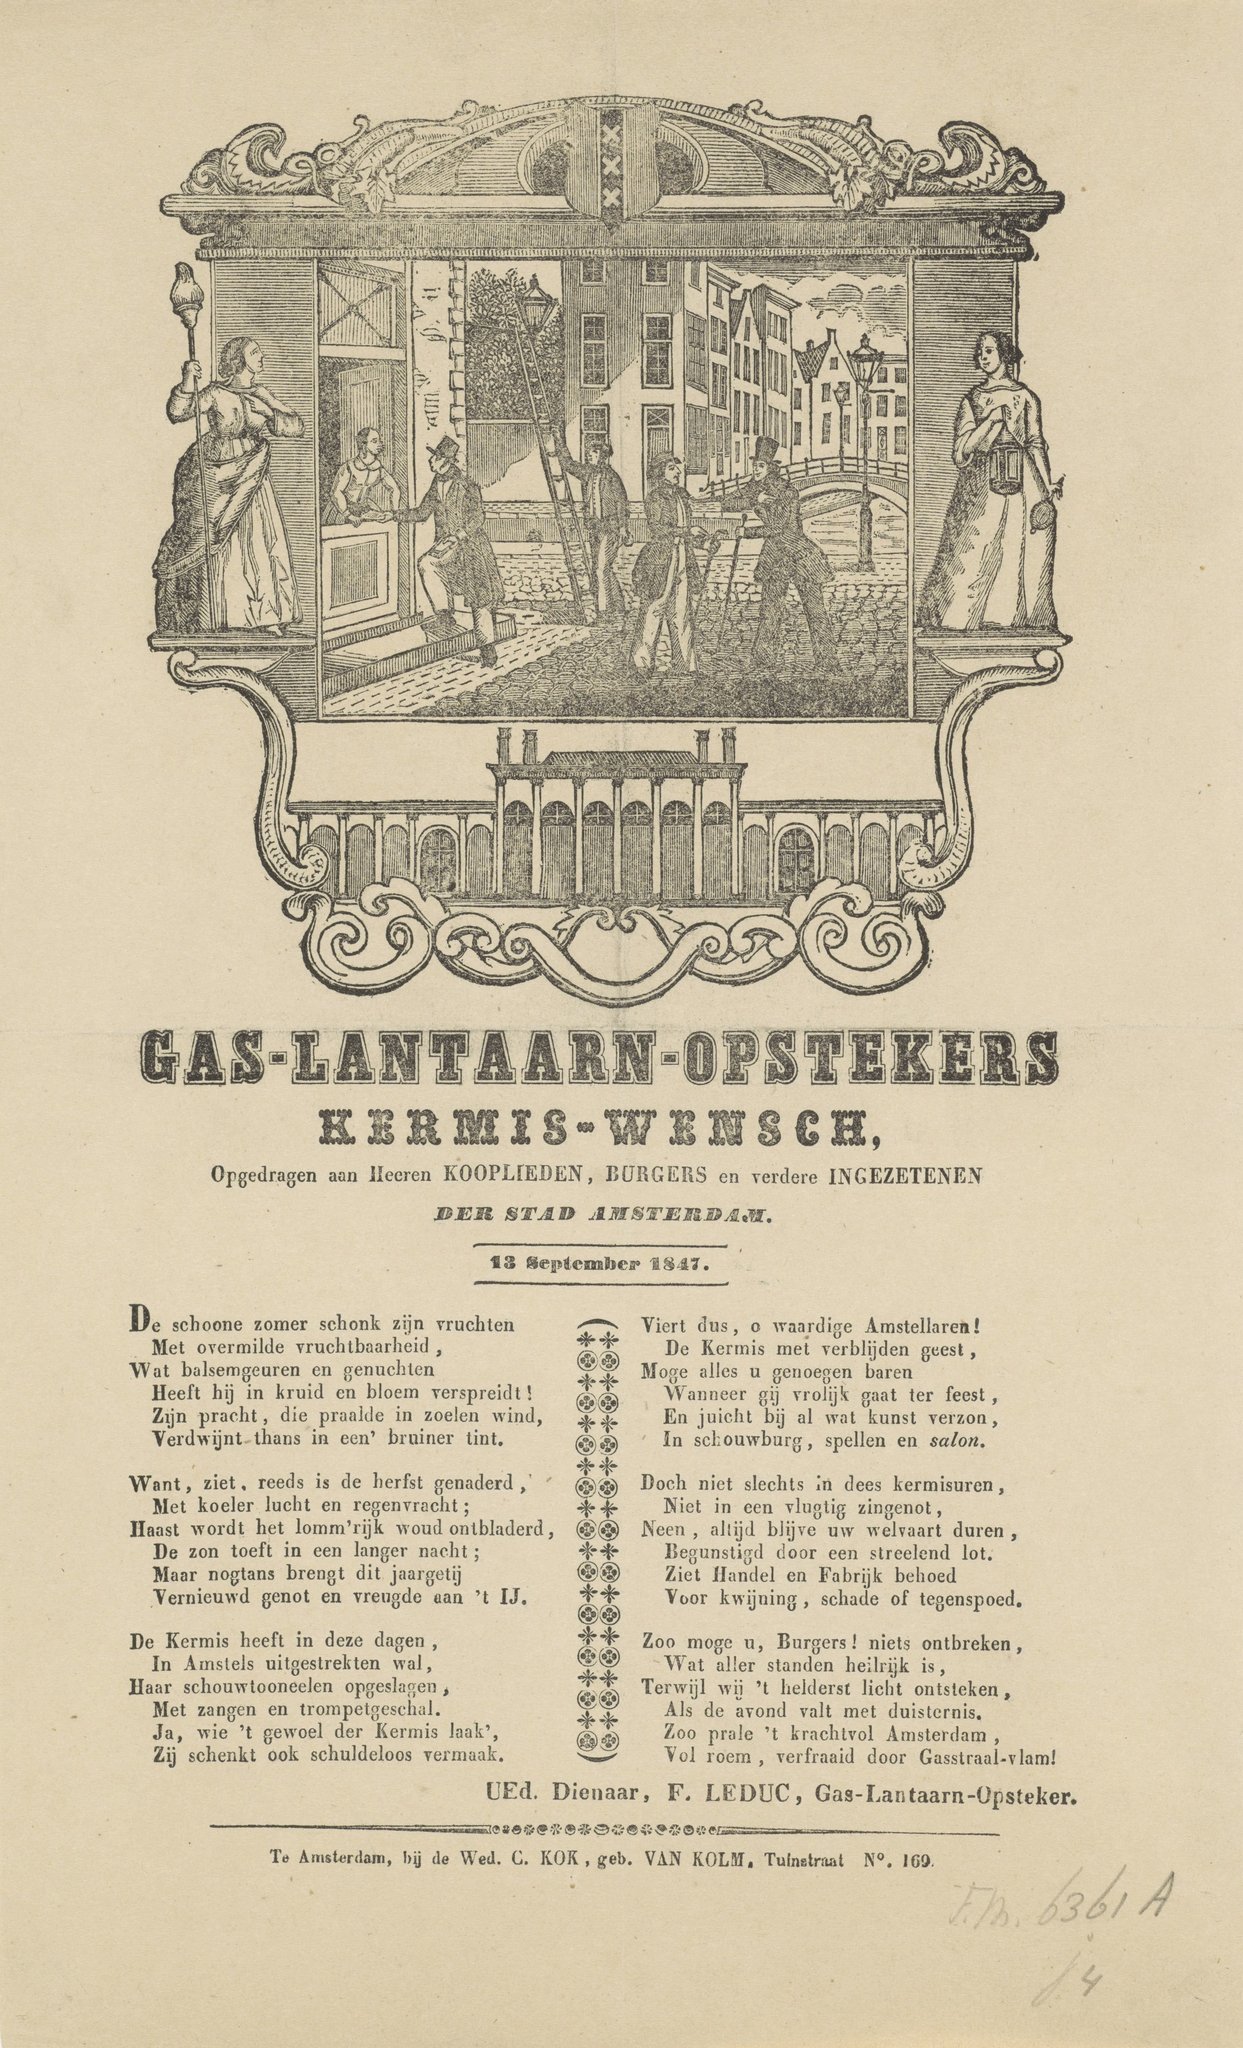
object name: print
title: Kermisprent van de gaslantaarnopstekers van Amsterdam voor het jaar 1847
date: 1847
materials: paper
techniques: letterpress printing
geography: amsterdam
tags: gas-lamp (+ kindling a light; lit, burning light, lamp, candle), street lighting, street, amsterdam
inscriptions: collector's mark: Lugt 2228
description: Kermisprent van de Amsterdamse gaslantaarnopstekers, 13 september 1847. Cartouche met een gezicht in een straat in Amsterdam waar enkele mannen bezig zijn de straatlantaarns aan te steken. Een andere man haalt geld op bij een huis. Links en rechts een staande vrouw met een fakkel en een olielantaarn, onderaan de Amsterdamse gasfabriek. Van de gaslantaarnopsteker: F. Leduc.